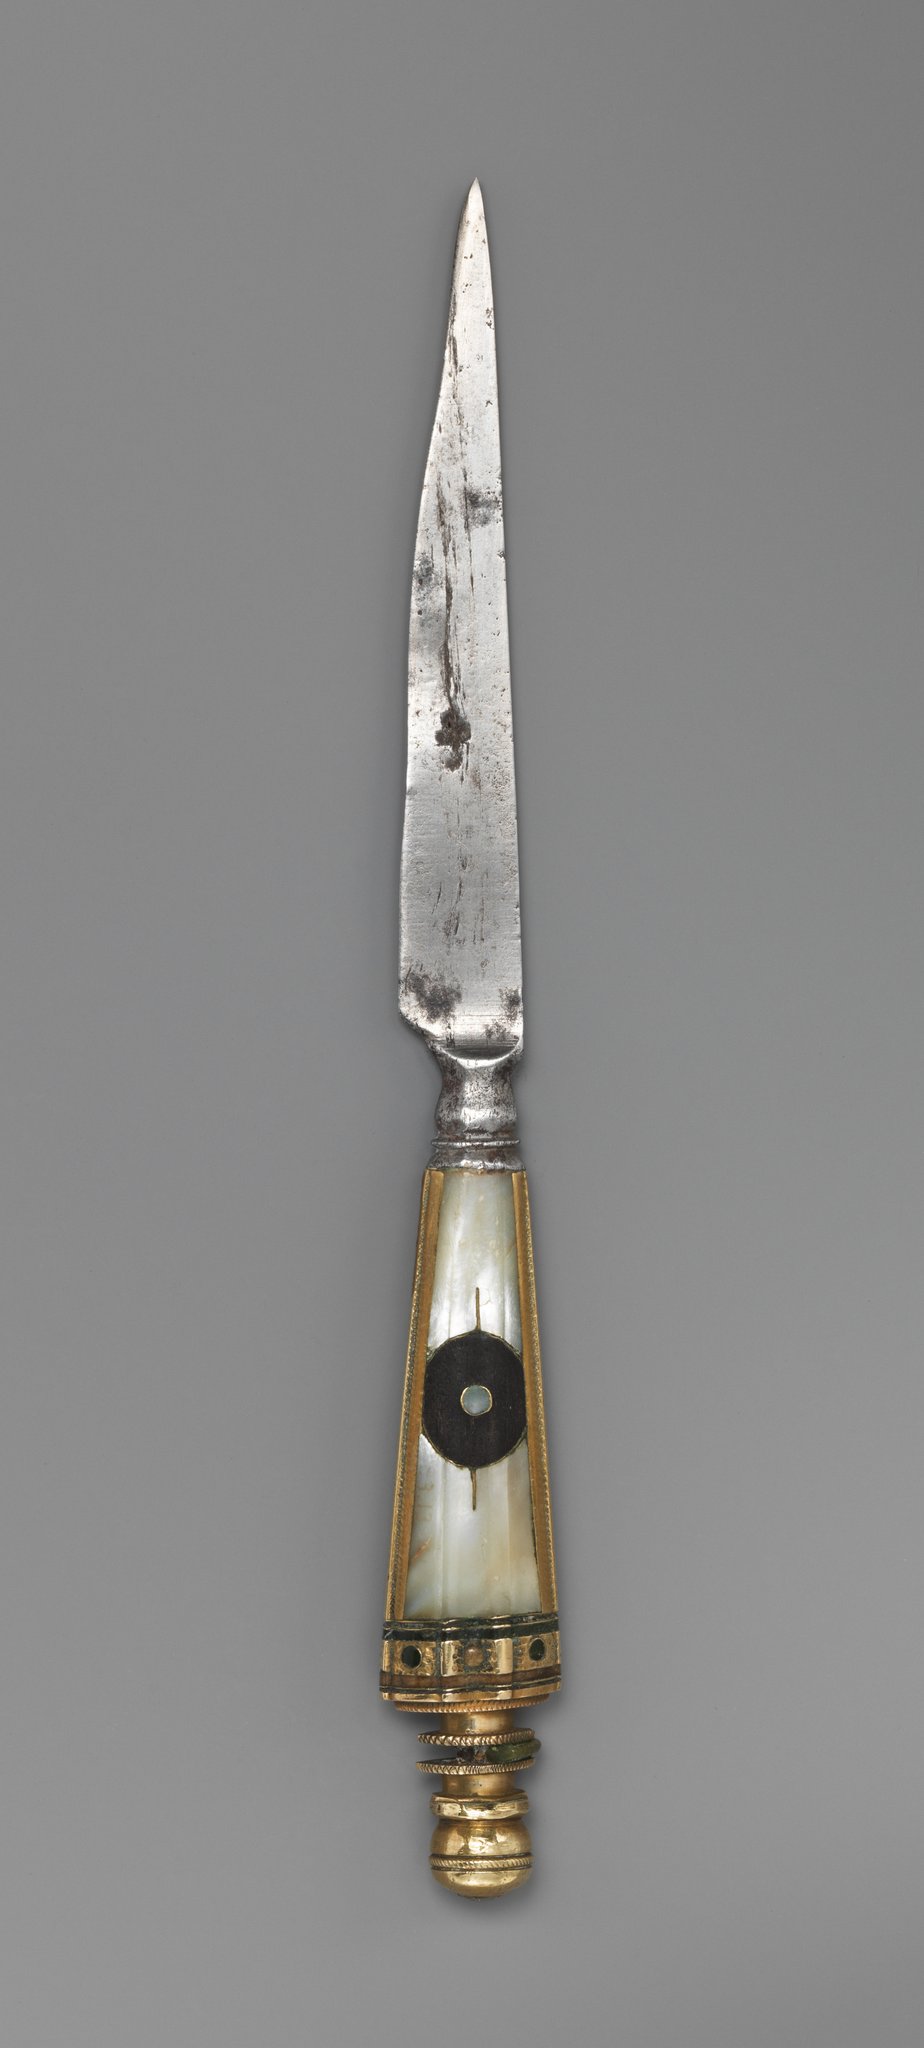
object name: table knife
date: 1601-1700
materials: gilt bronze, mother of pearl, paste, steel